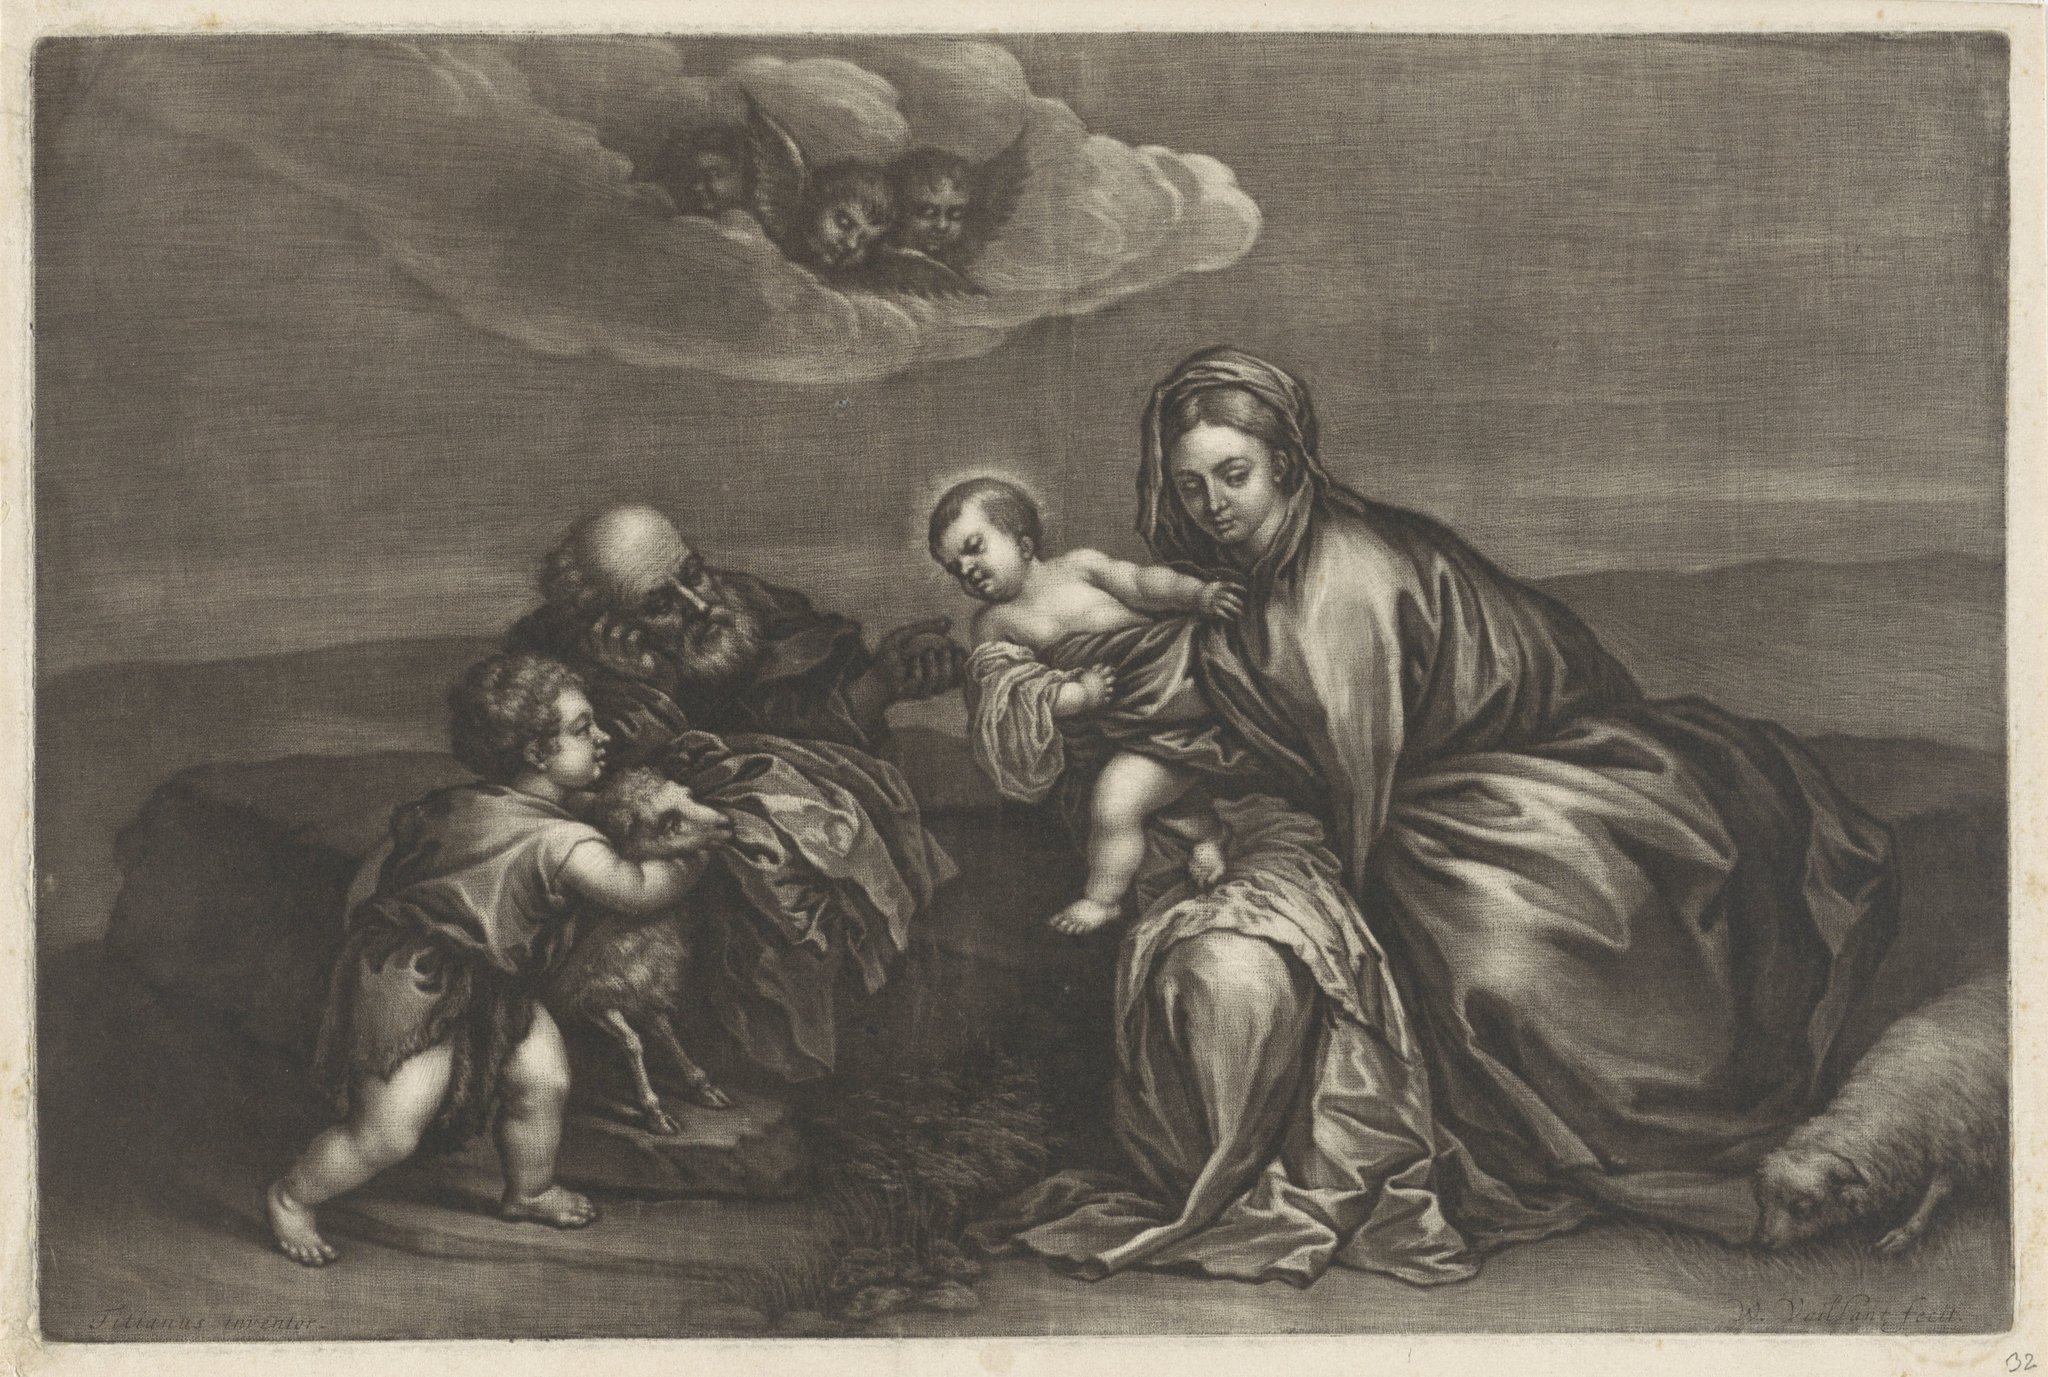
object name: print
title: De Heilige Familie met Johannes de Doper in een landschap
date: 1658-1677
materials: paper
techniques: mezzotint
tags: holy family with john the baptist (as child)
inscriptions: collector's mark: Lugt 240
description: Maria en Jozef met het Christuskind in een landschap. Naast Jozef staat Johannes de Doper als kind met zijn lam. In de wolken drie engeltjes.